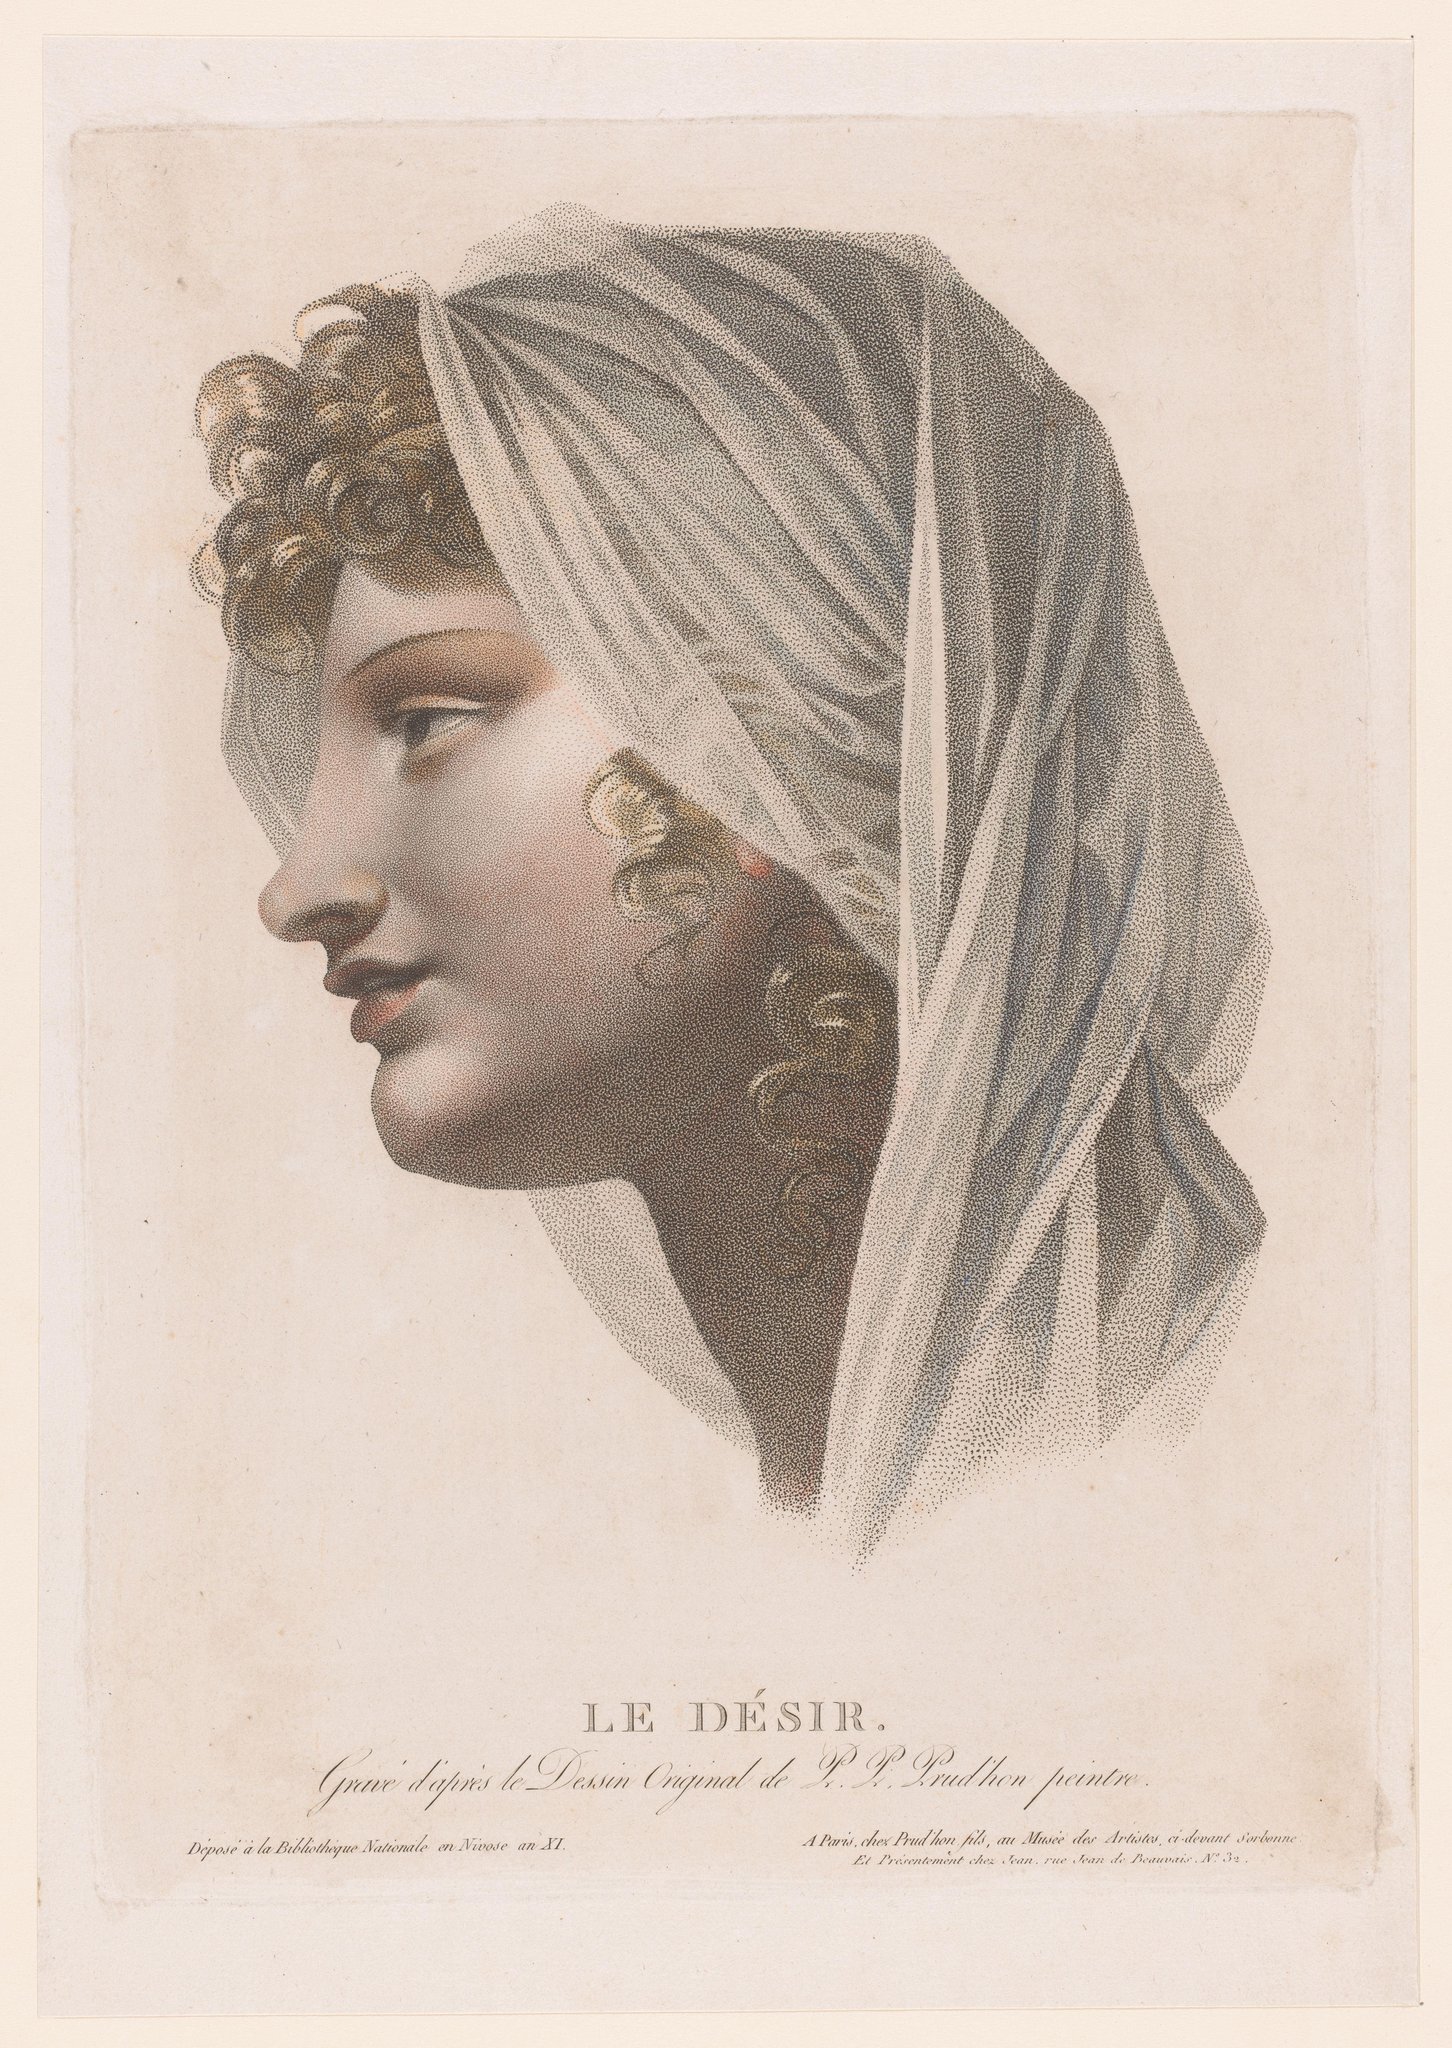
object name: print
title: Verlangen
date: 1802-1803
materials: paper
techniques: etching, hand coloring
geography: paris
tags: adult woman, desire; 'desiderio' (ripa)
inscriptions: collector's mark: Lugt 2228, : ‘Déposé à la Bibliothèque Nationale’